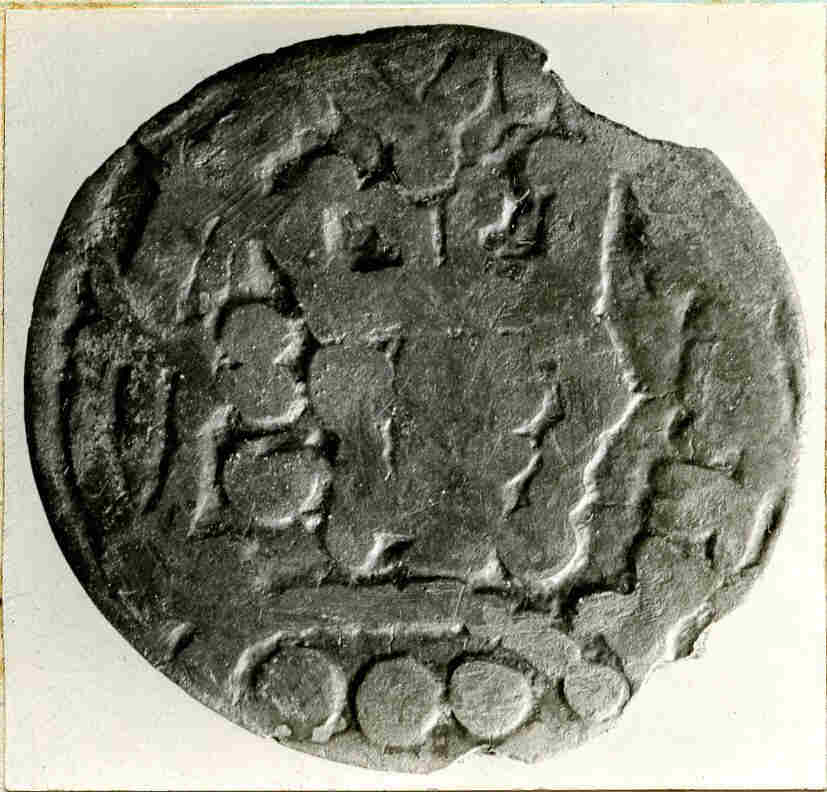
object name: coin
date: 749-810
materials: silver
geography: iran